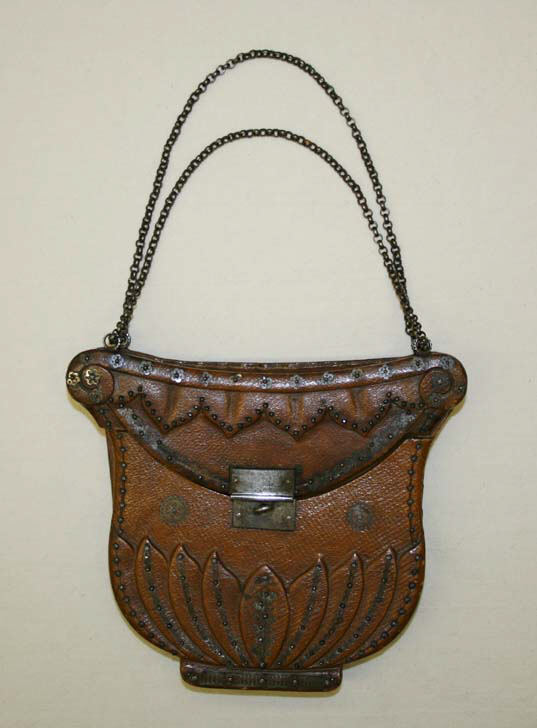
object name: purse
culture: french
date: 1790-1800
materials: leather, metal